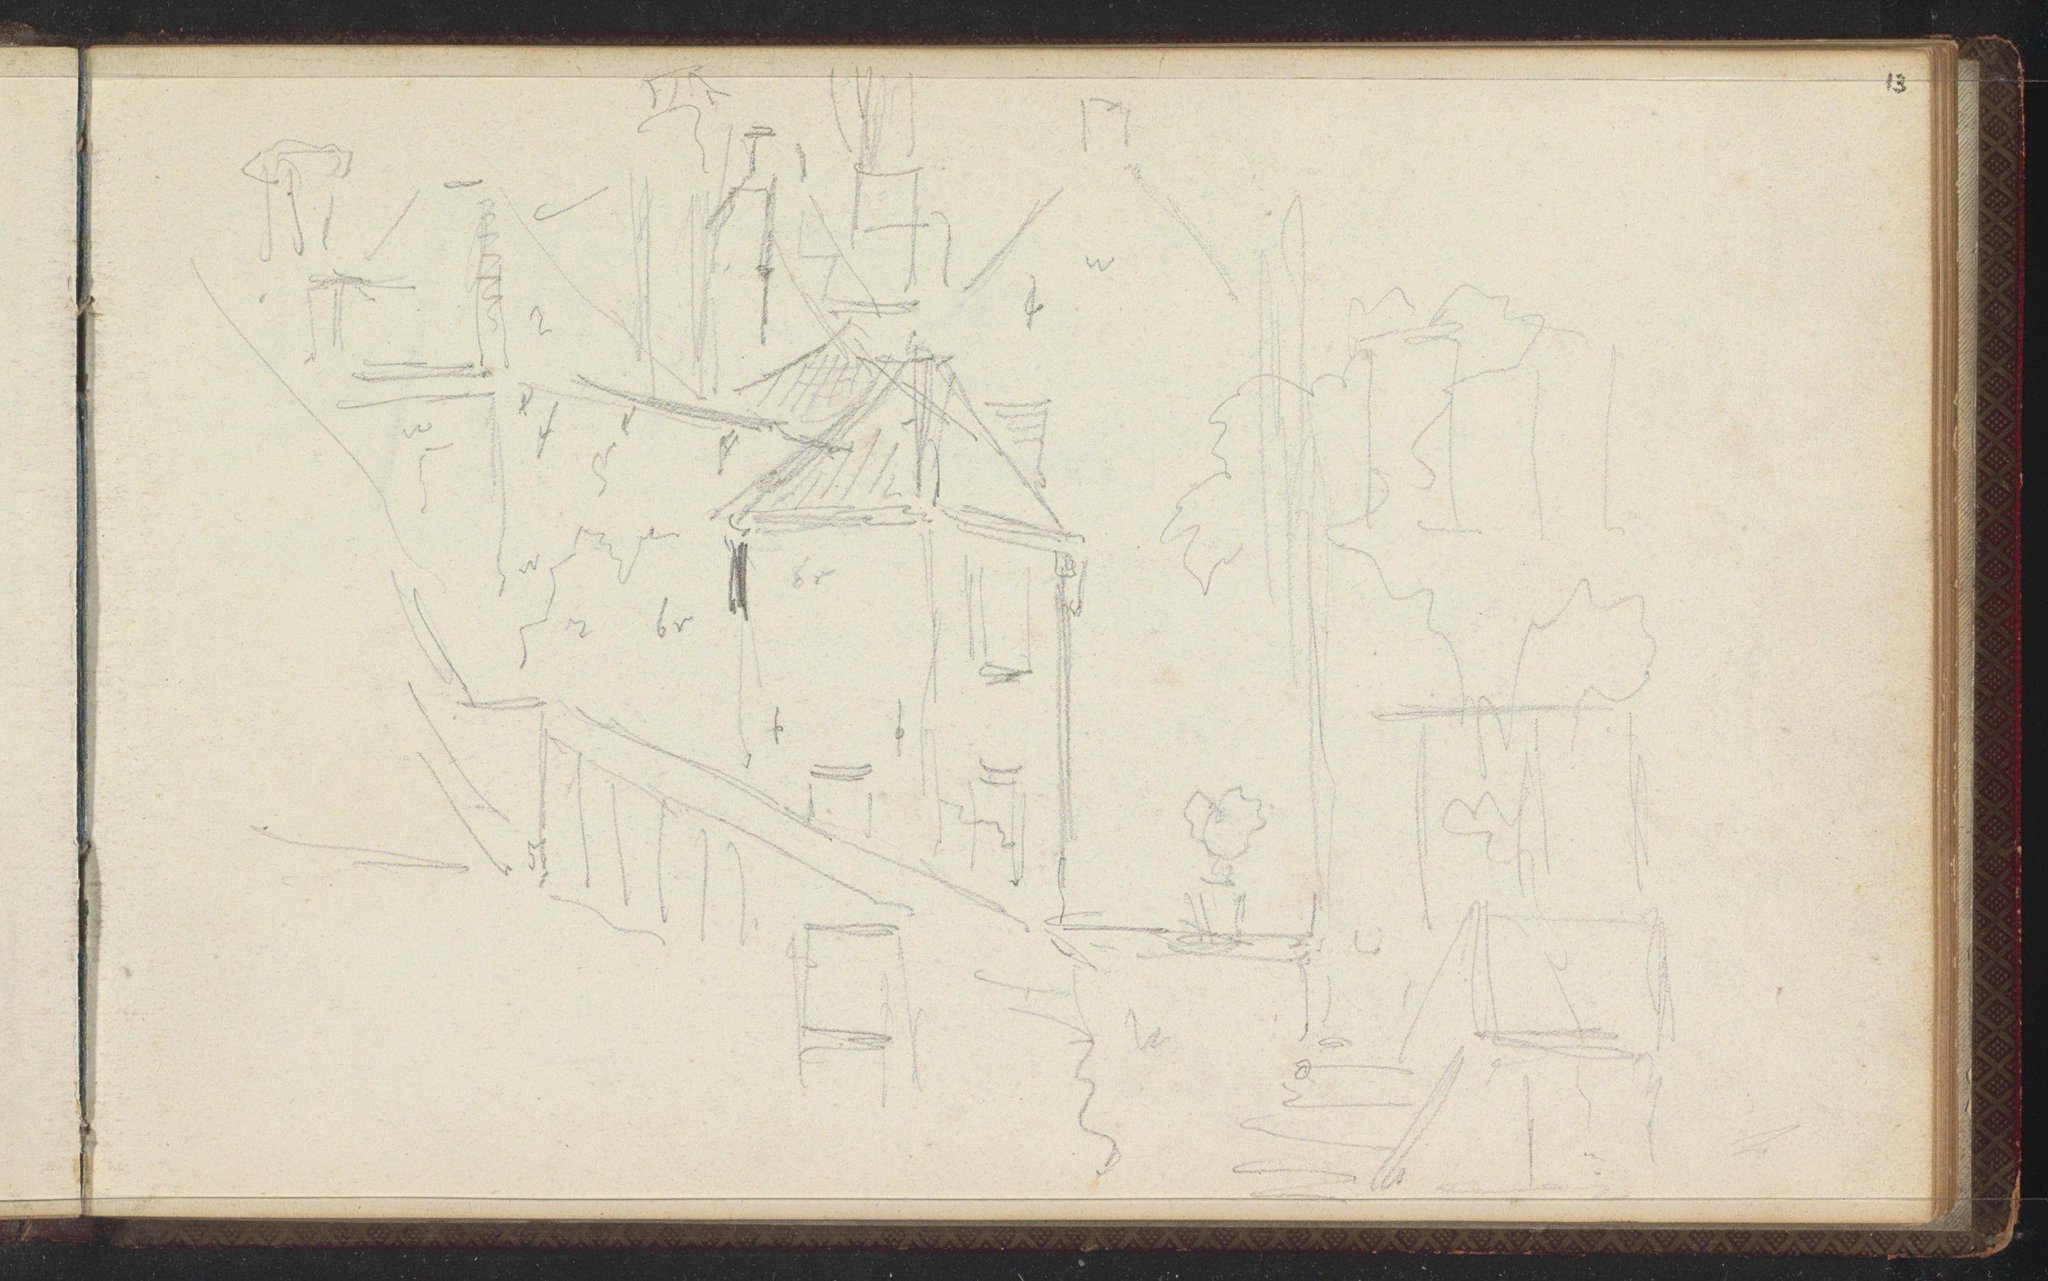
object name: sketchbook leaf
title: Gezicht op een groep gebouwen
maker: adrianus eversen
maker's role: draughtsman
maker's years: 1818-1897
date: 1828-1897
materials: paper, pencil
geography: netherlands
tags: urban housing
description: Gezicht op een groep gebouwen. Blad 13 recto uit een schetsboek met 52 bladen vervaardigd in de omgeving van Kampen, Hattem, Hoorn en Zwolle.